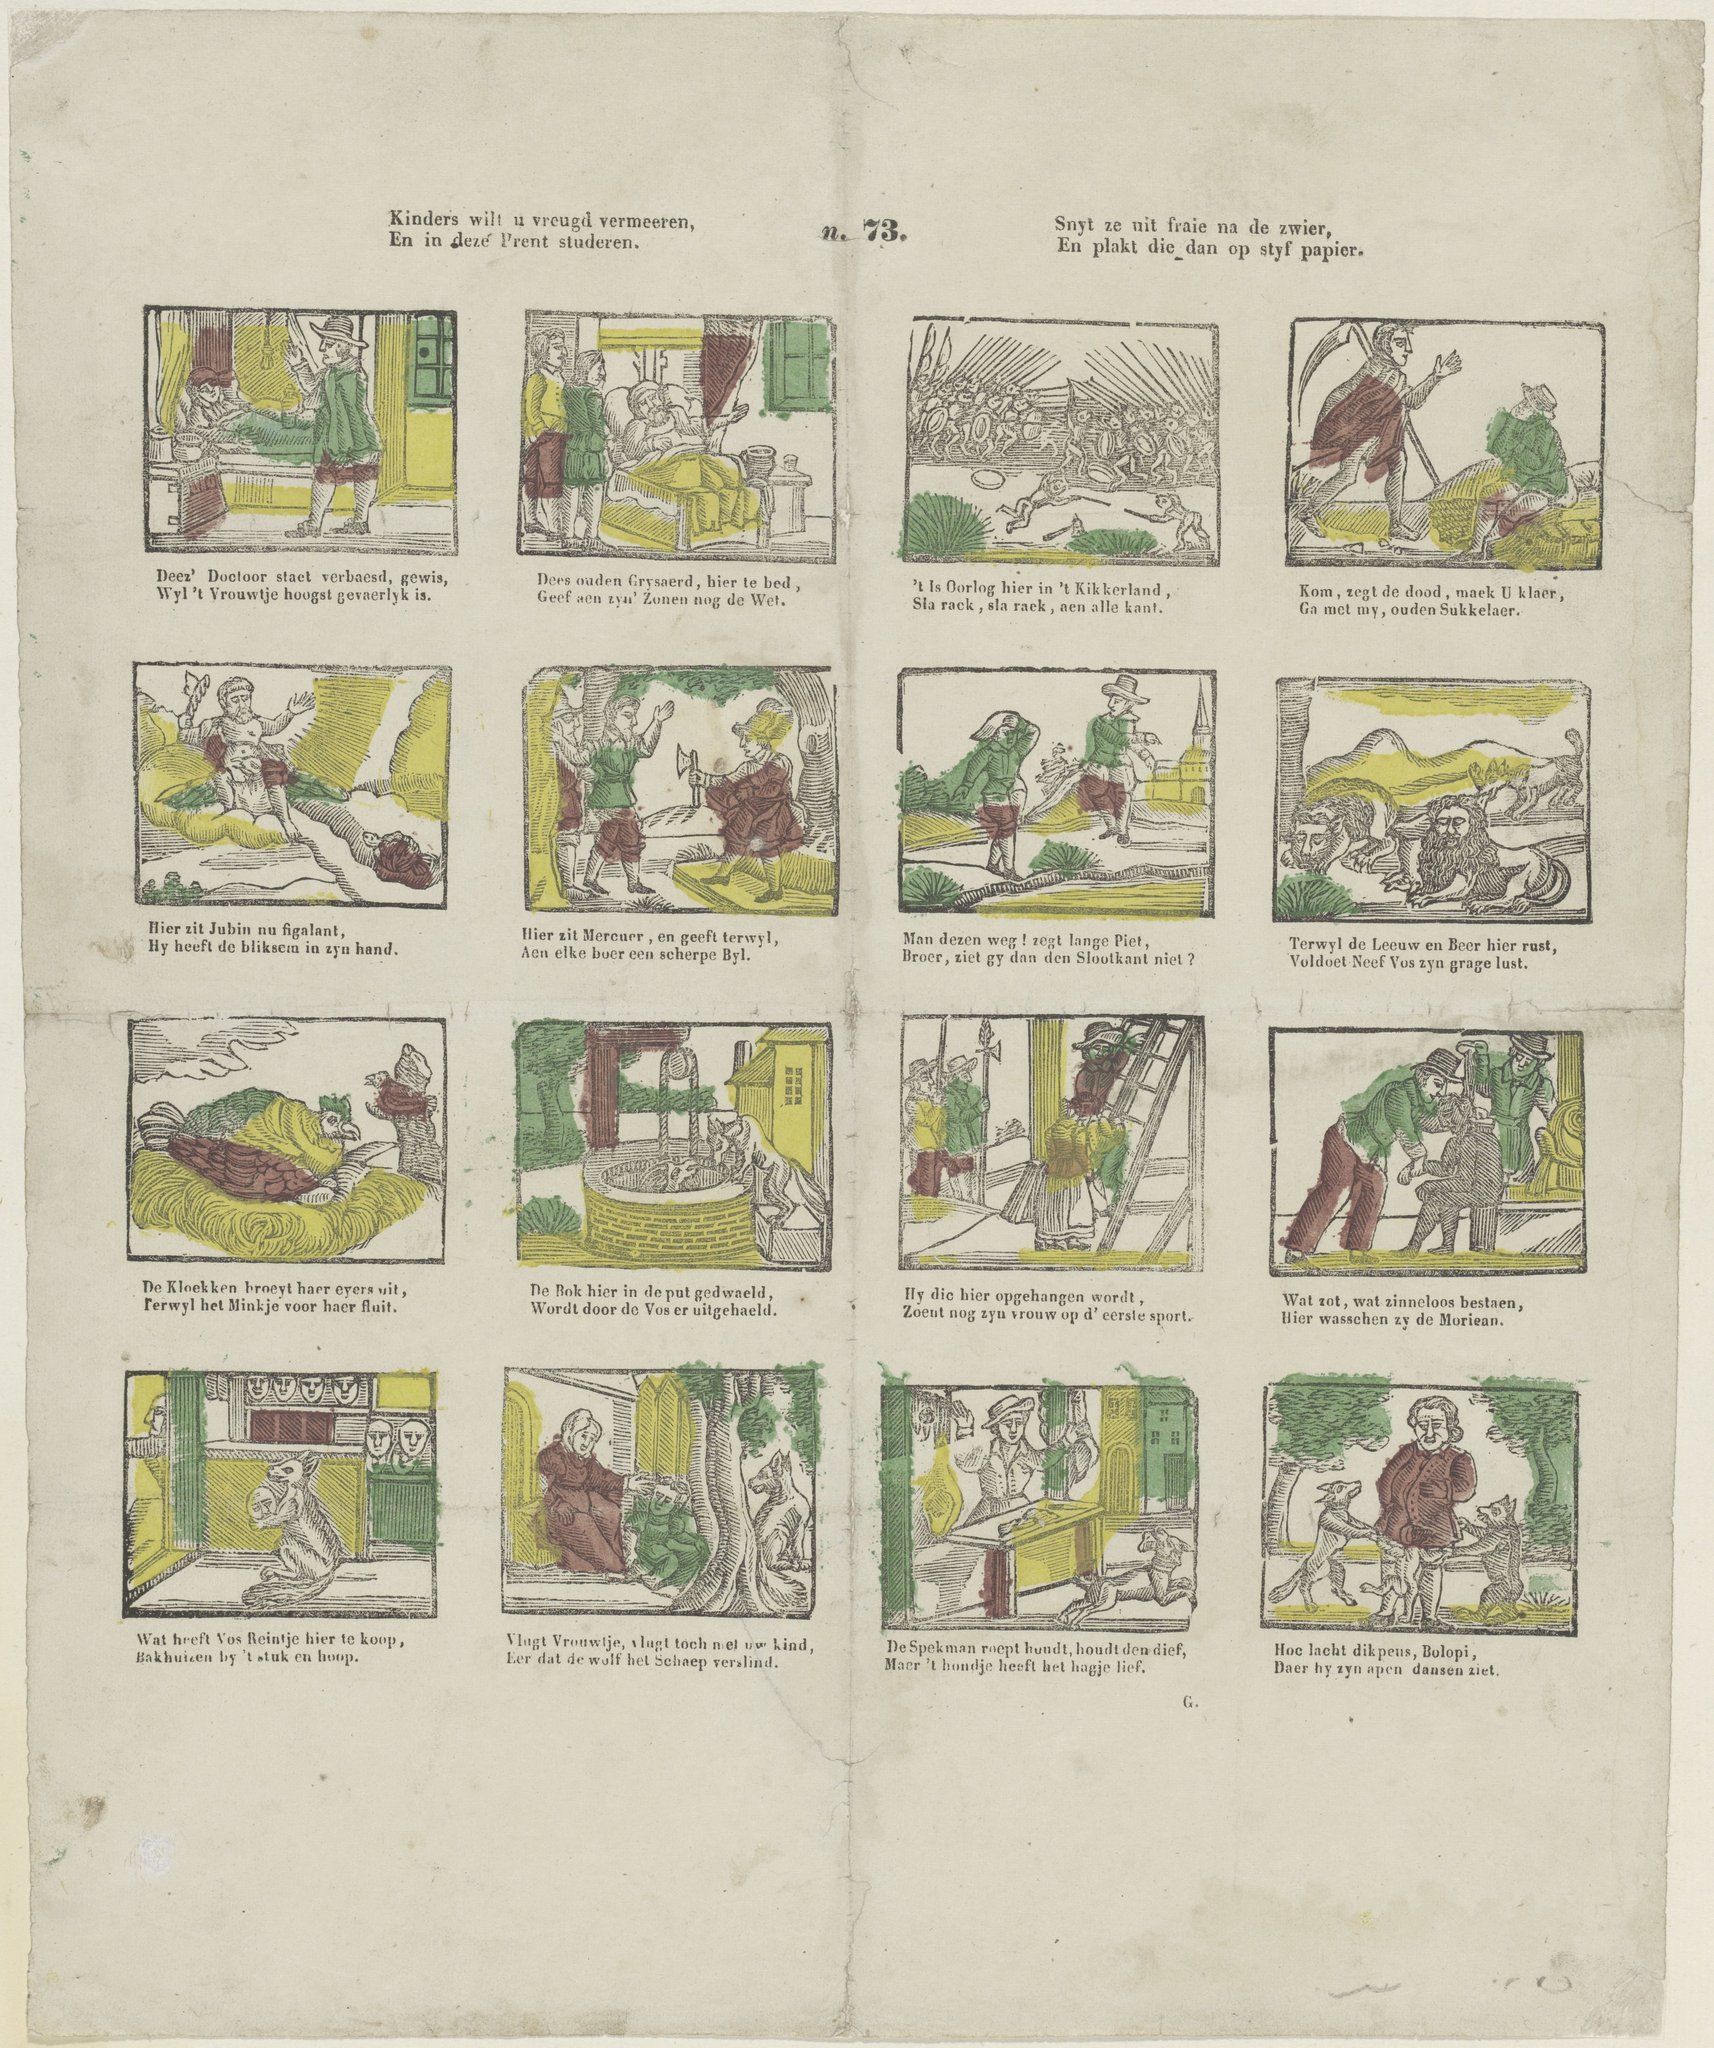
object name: print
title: Kinders wilt u vreugd vermeeren, / En in deze prent studeren / Snyt ze uit fraie na de zwier, / En plakt die dan op styf papier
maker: Anonymous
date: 1833-1900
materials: paper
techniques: colour, letterpress printing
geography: netherlands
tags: animals, characters (human types), fables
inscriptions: collector's mark: Lugt 2760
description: Blad met 16 voorstellingen van verschillende aard (fabelen van Aesopus?). Onder elke voorstelling een tweeregelig vers. Genummerd midden boven: n. 73.